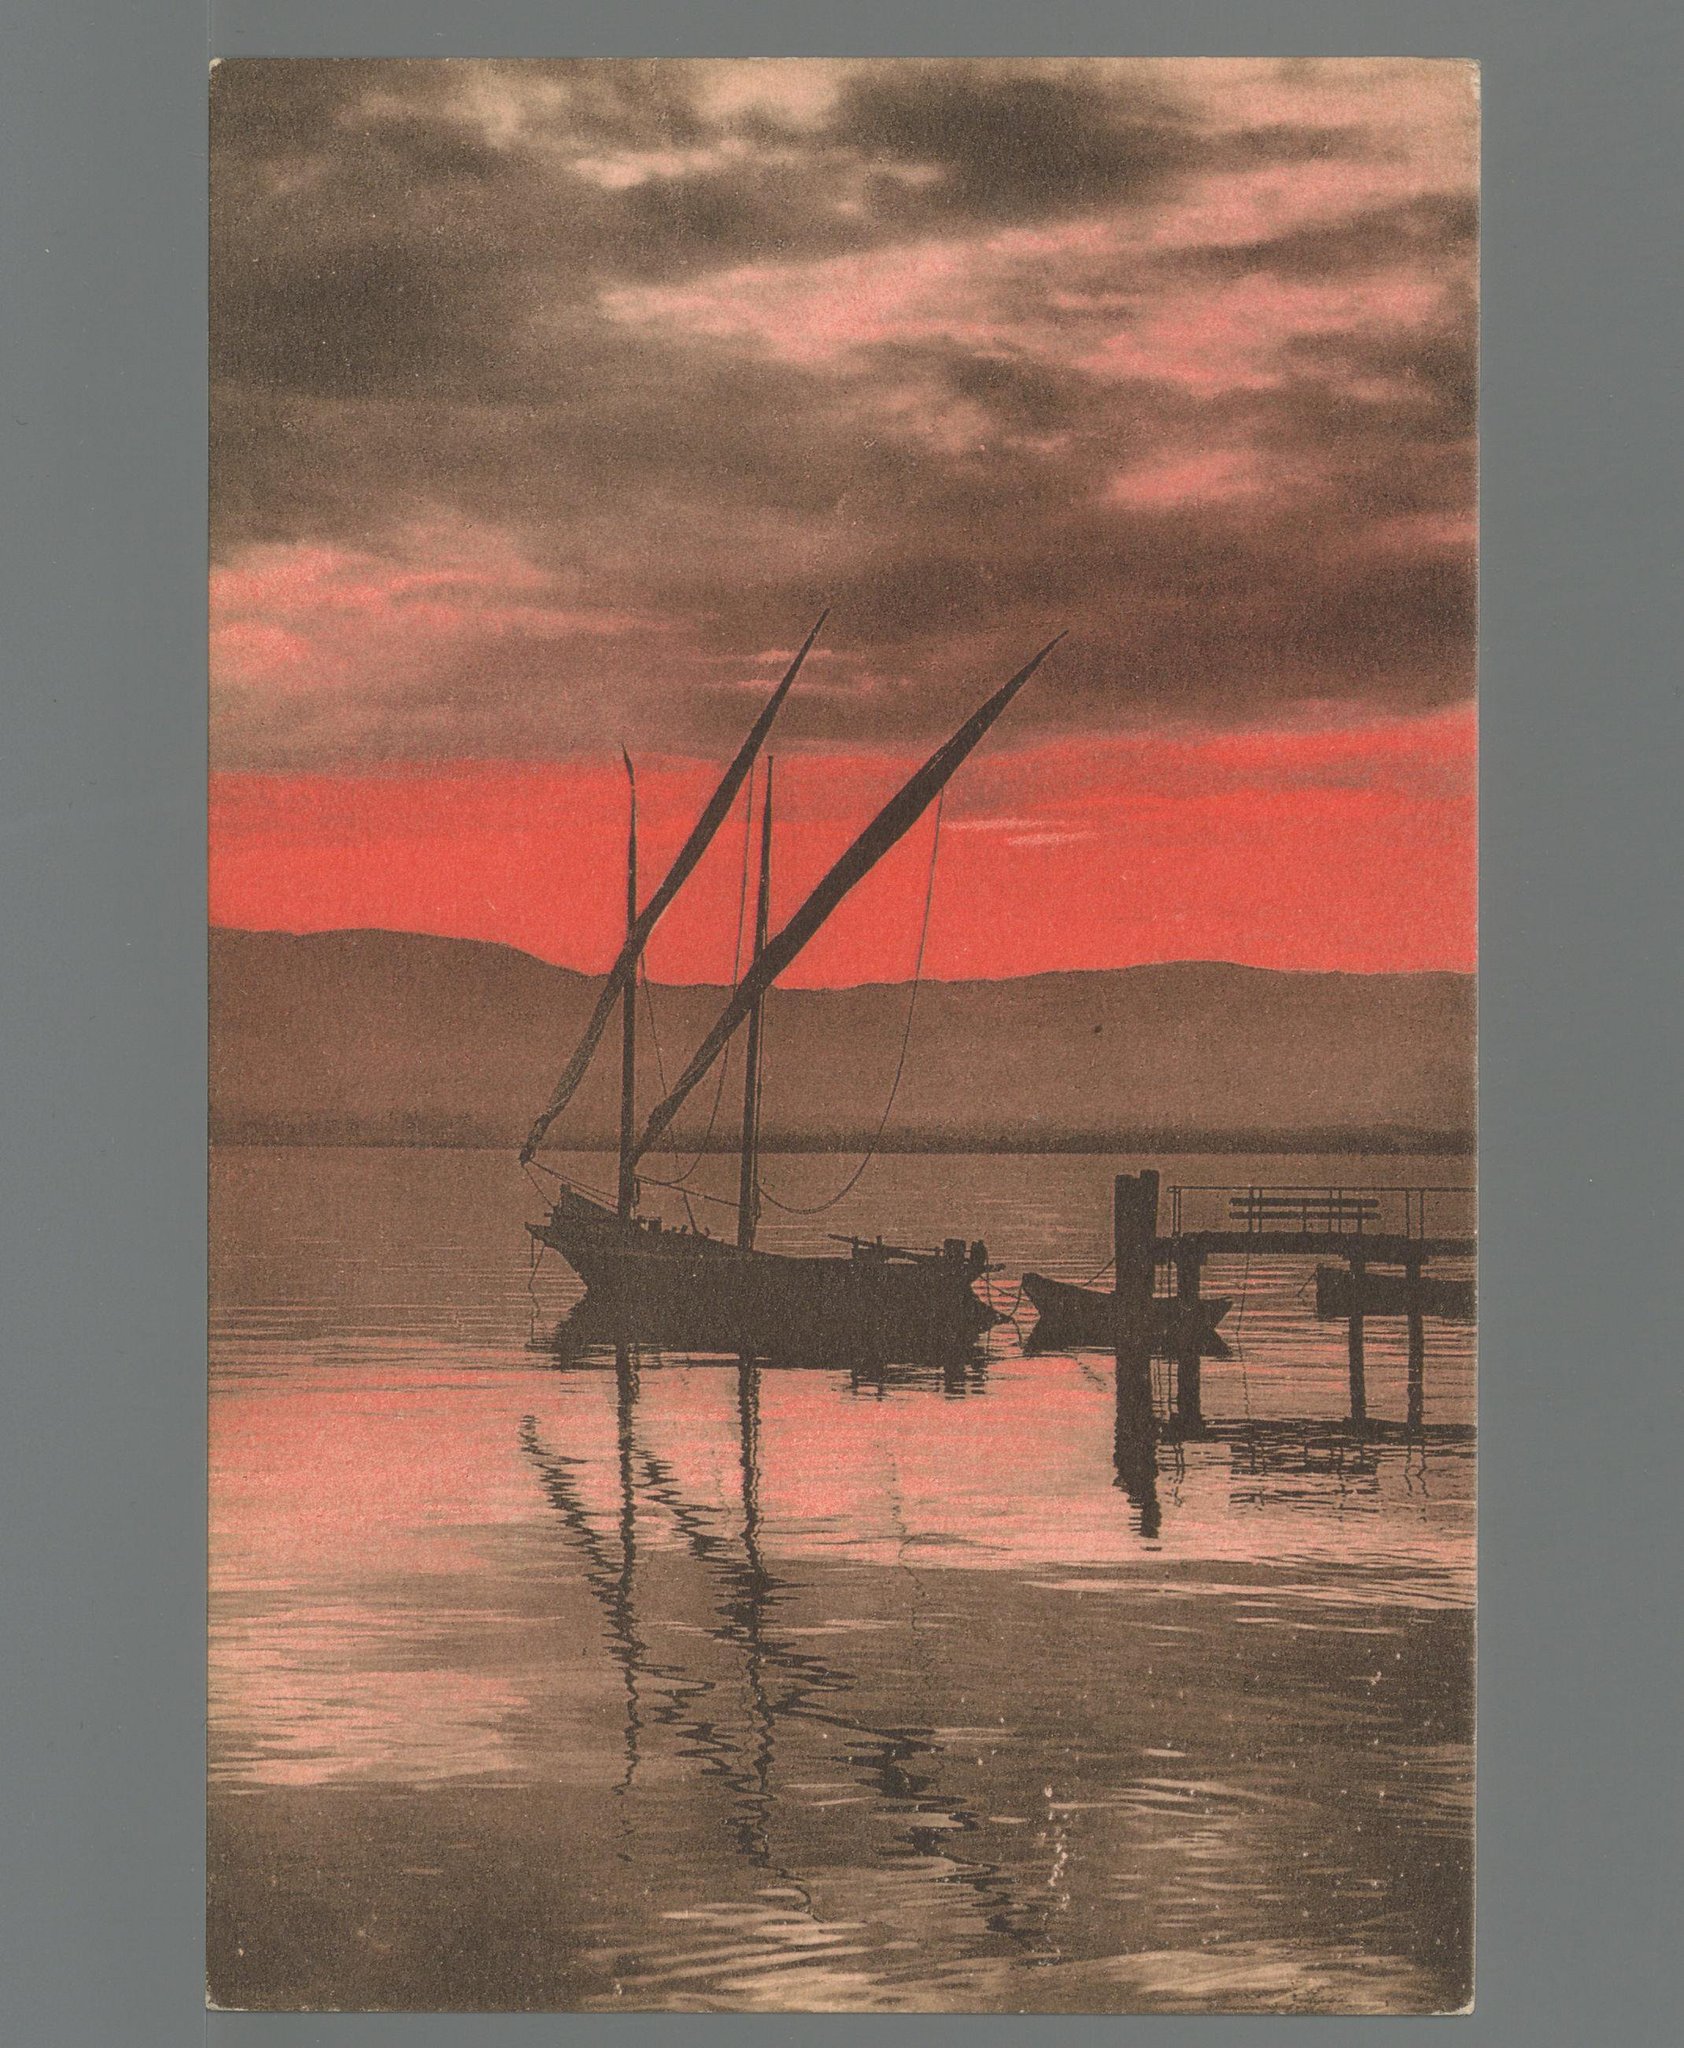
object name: photomechanical print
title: Lac Léman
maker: Anonymous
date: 1905-1909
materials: cardboard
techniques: photograph, lithograph, writing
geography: geneva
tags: sailing-ship, sailing-boat, lake